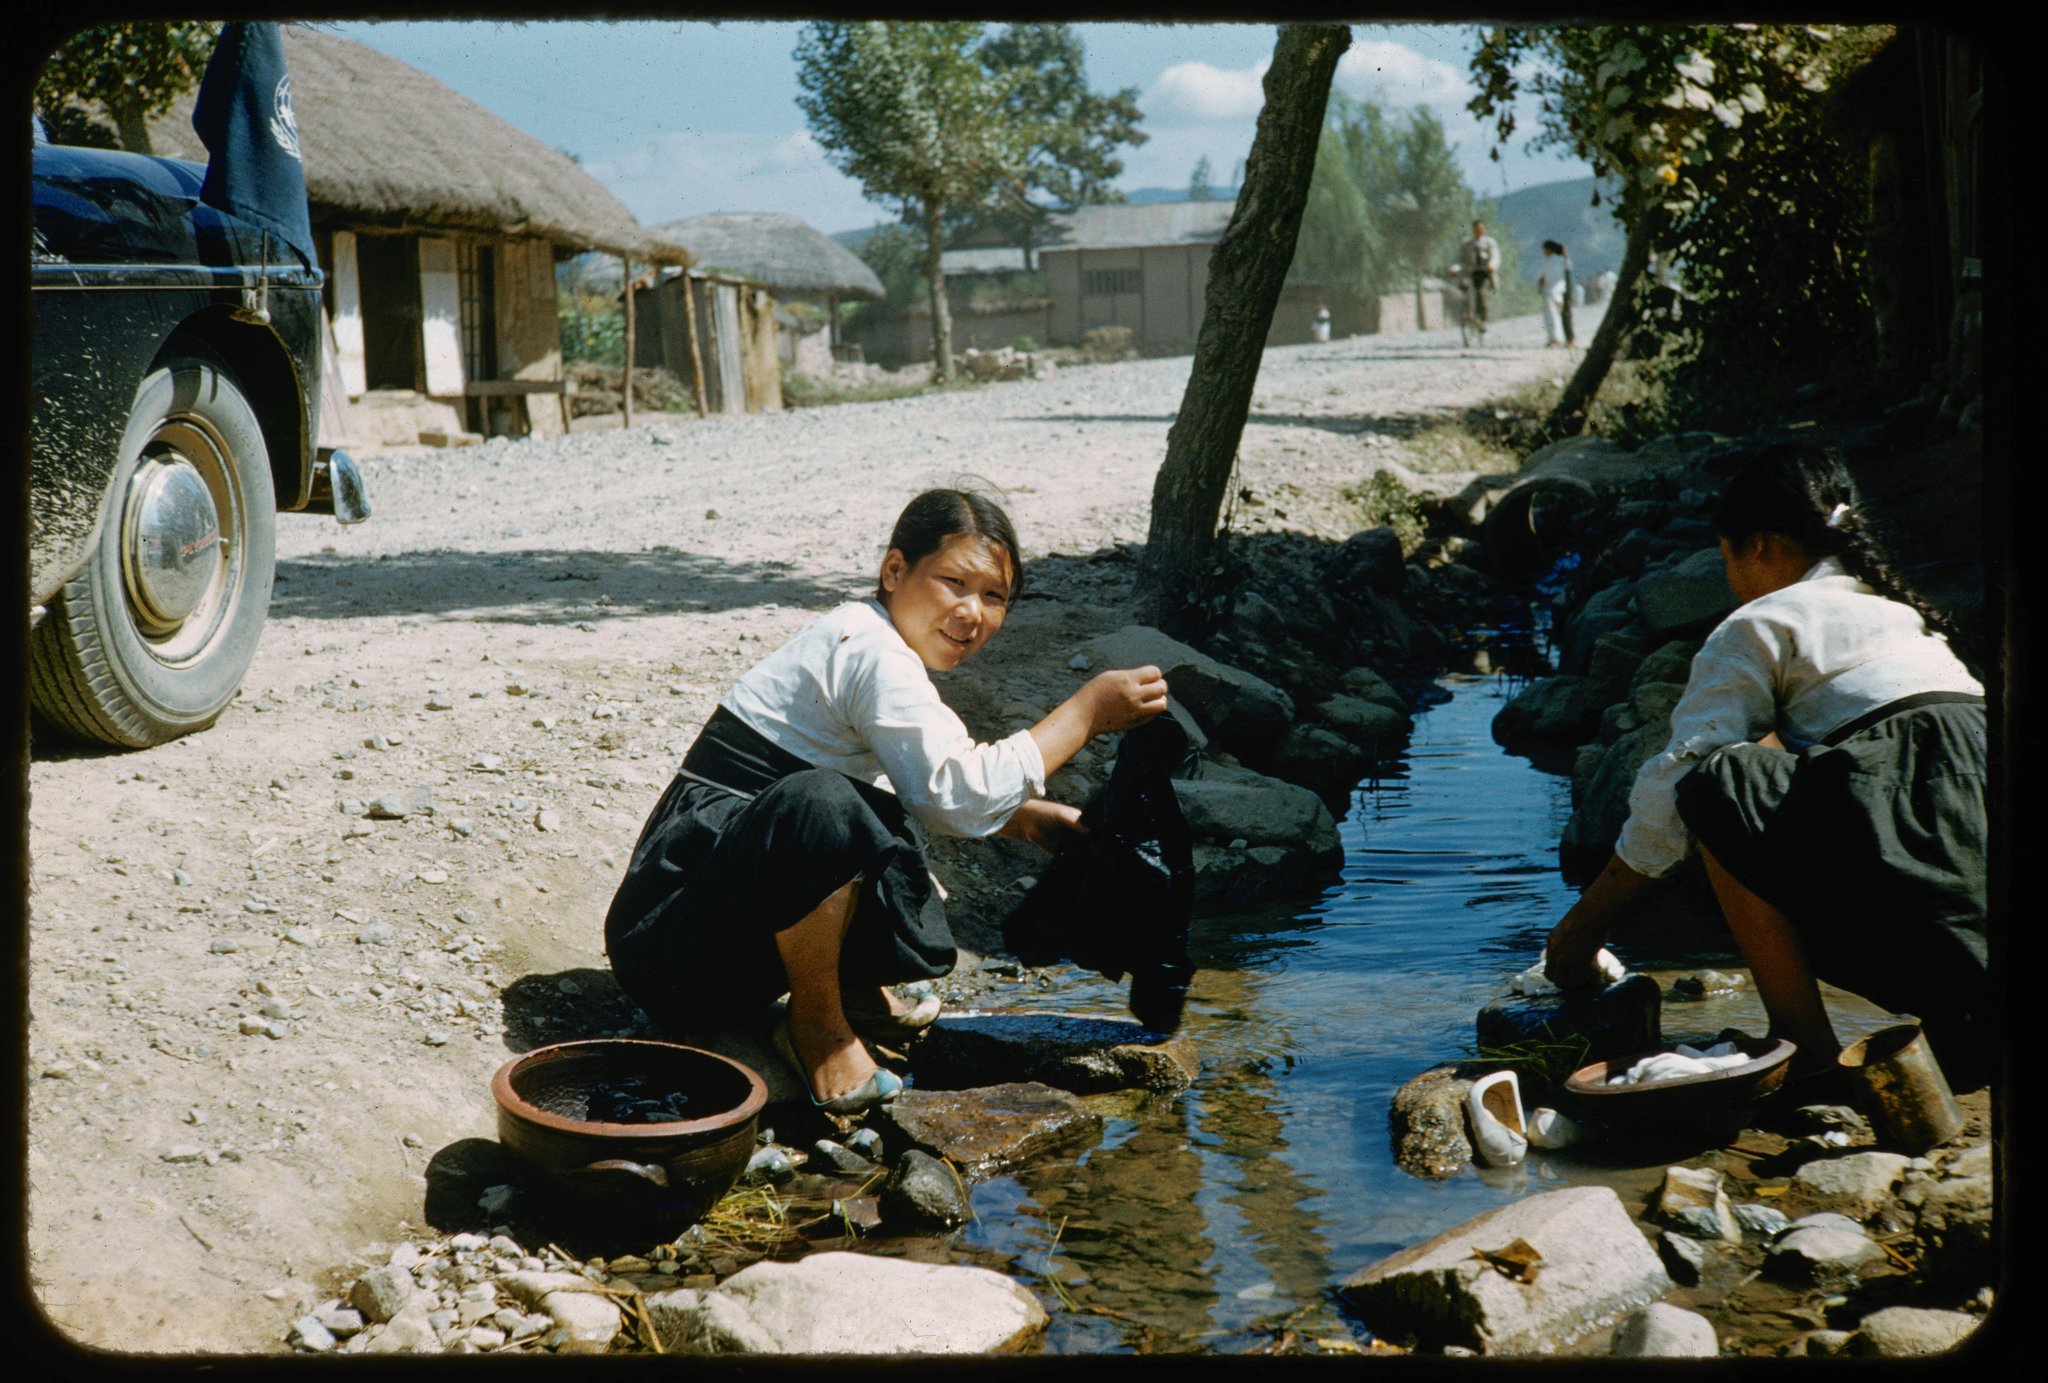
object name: color slide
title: Oorlog in Korea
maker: david ketel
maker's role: diplomaat, sinoloog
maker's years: 1913-2008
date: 1951-1953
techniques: slide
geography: korea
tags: united nations